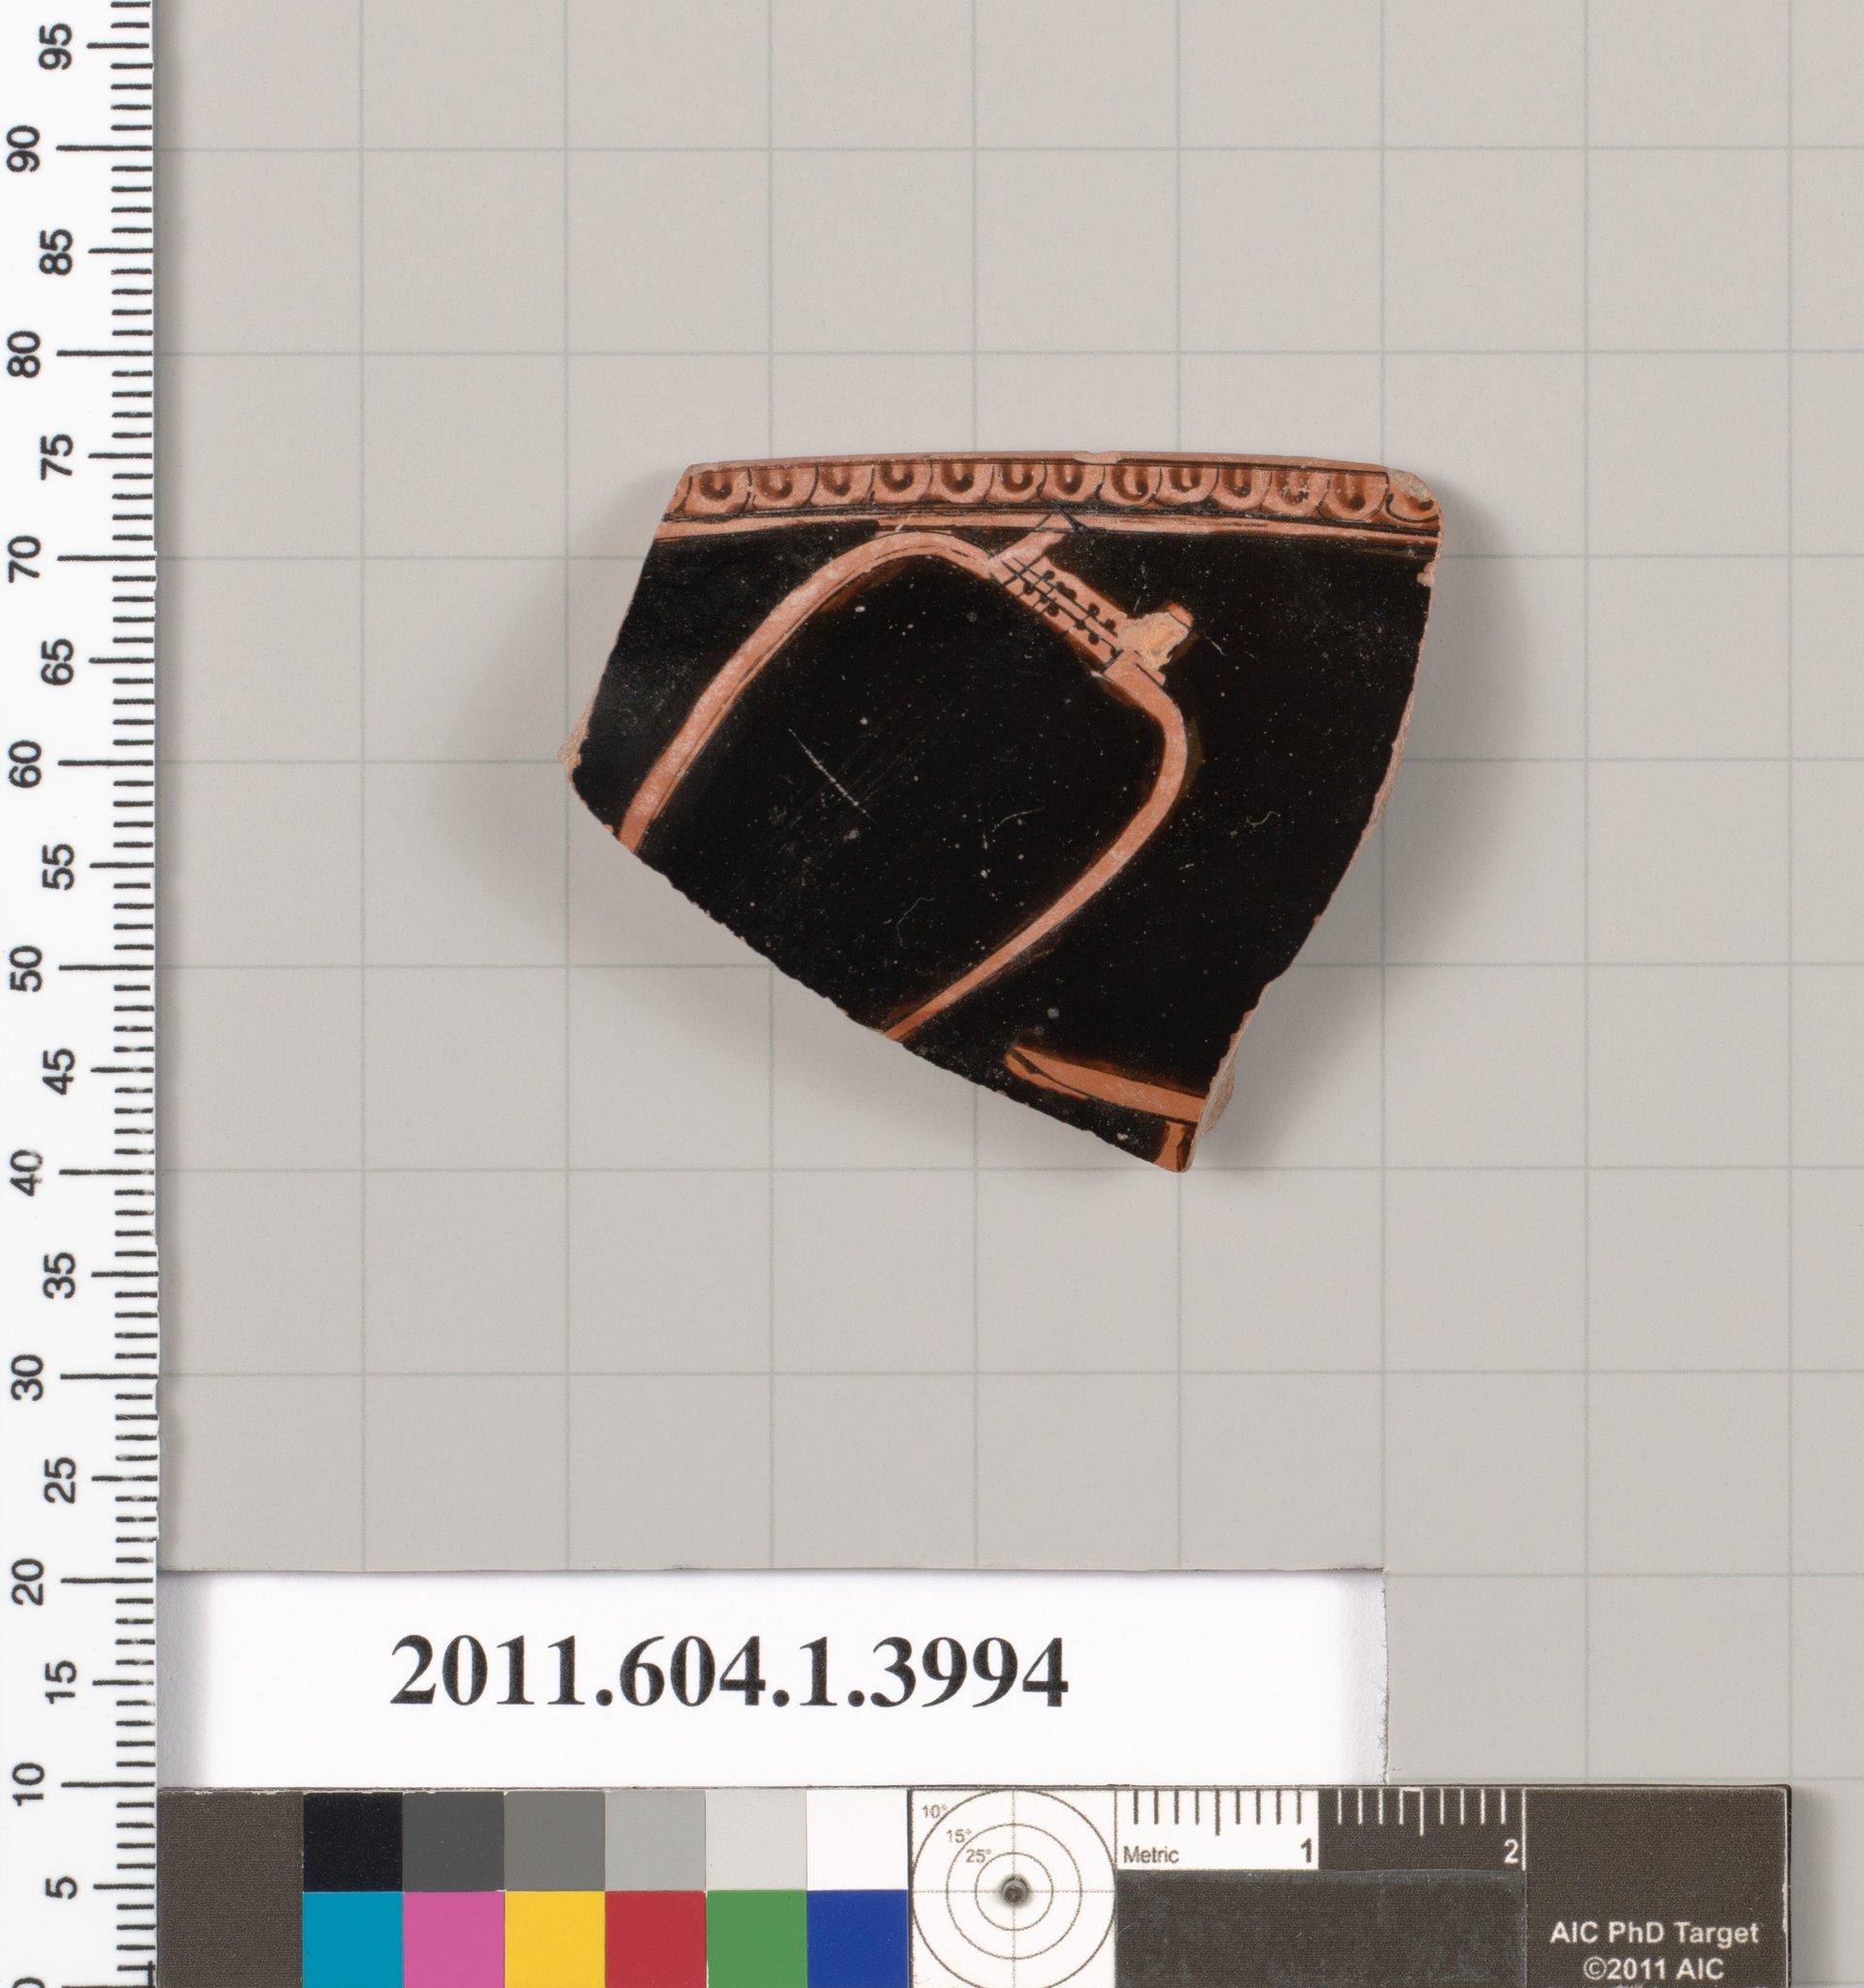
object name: kylix fragment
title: Terracotta fragment of a kylix (drinking cup)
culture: greek, attic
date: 475-451 BCE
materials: terracotta